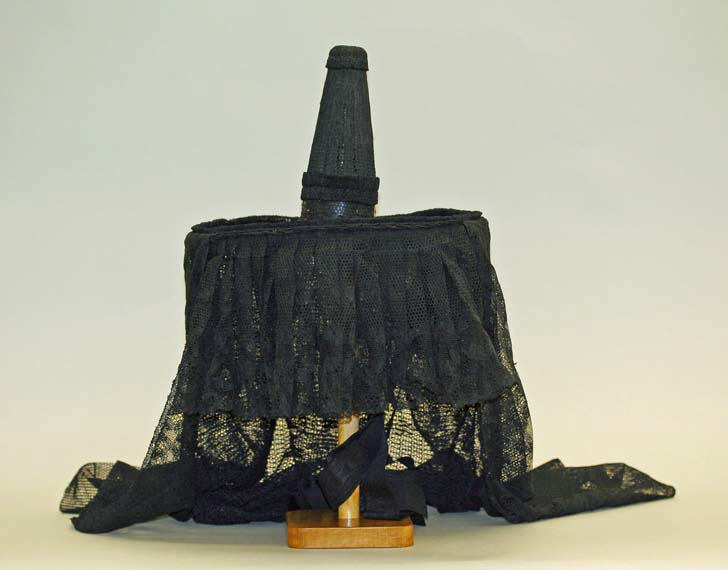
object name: headdress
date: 1801-1900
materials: cotton